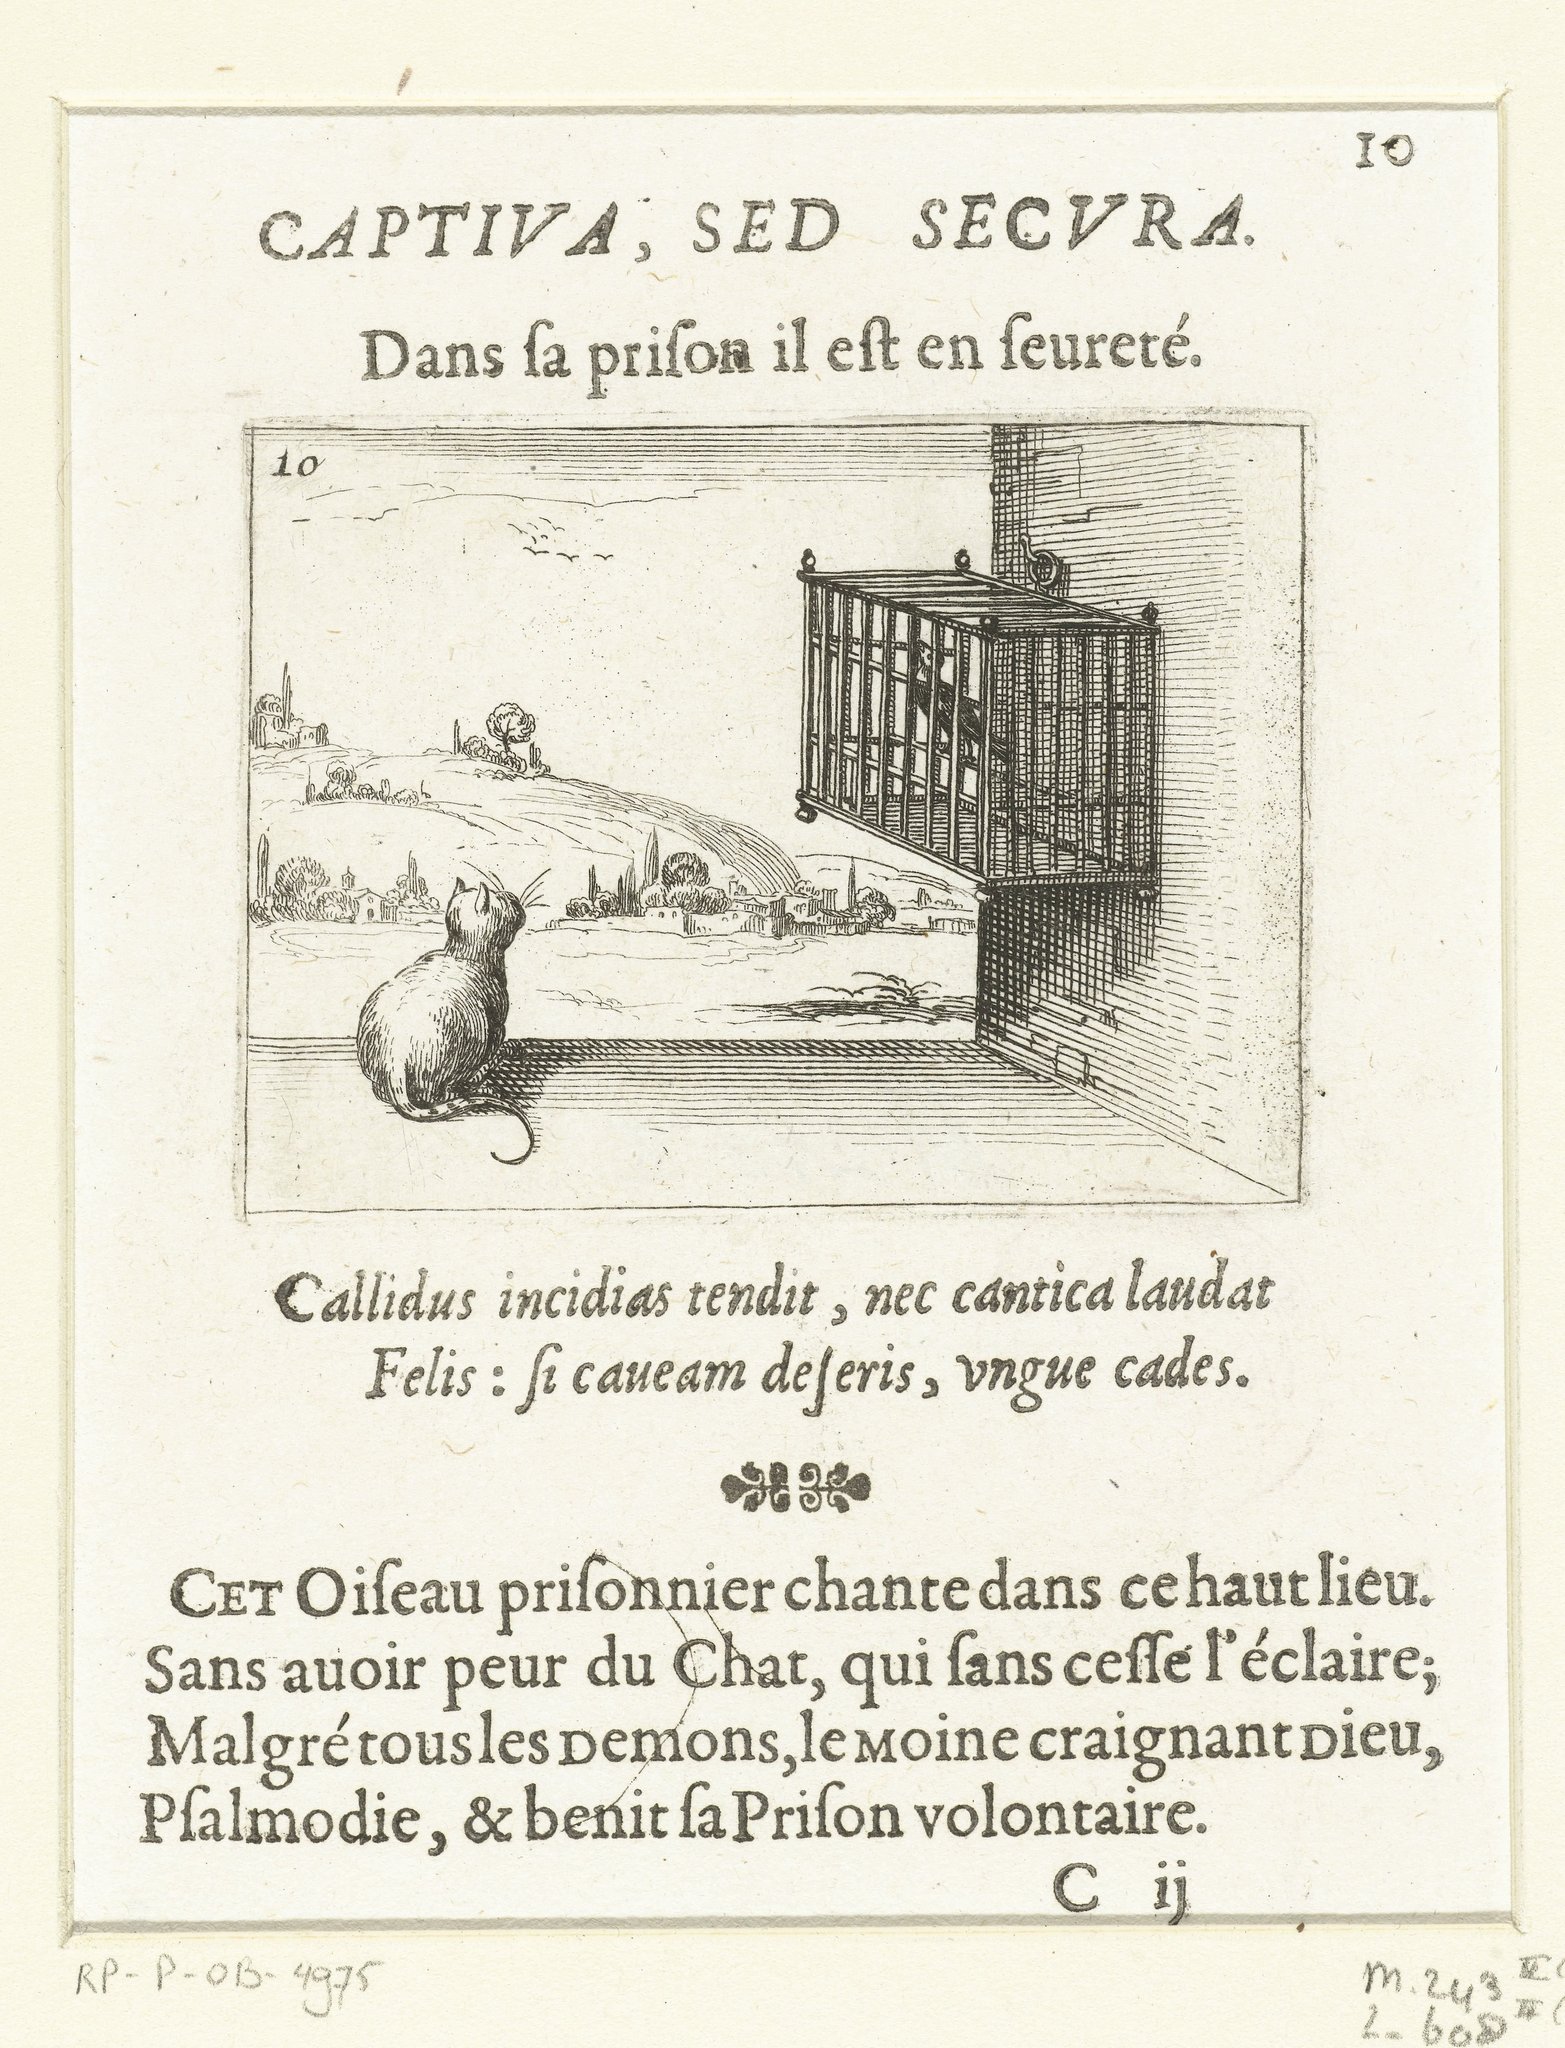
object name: print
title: Kat en gekooide vogel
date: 1621-1635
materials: paper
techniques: etching, letterpress printing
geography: paris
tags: cat, bird in a cage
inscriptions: collector's mark: Lugt 240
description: Voorstelling van een kat die loert naar een vogel in een kooi. Boven en onder deze prent Latijnse en Franse teksten in boekdruk. Dit blad is onderdeel van de embleemserie 'Kloosterleven in emblemen'. De tweede staat van deze serie behelst naast een geïllustreerde titelpagina en 26 emblemen nog een titelpagina en een blad met opdracht, beide in boekdruk zonder afbeelding.